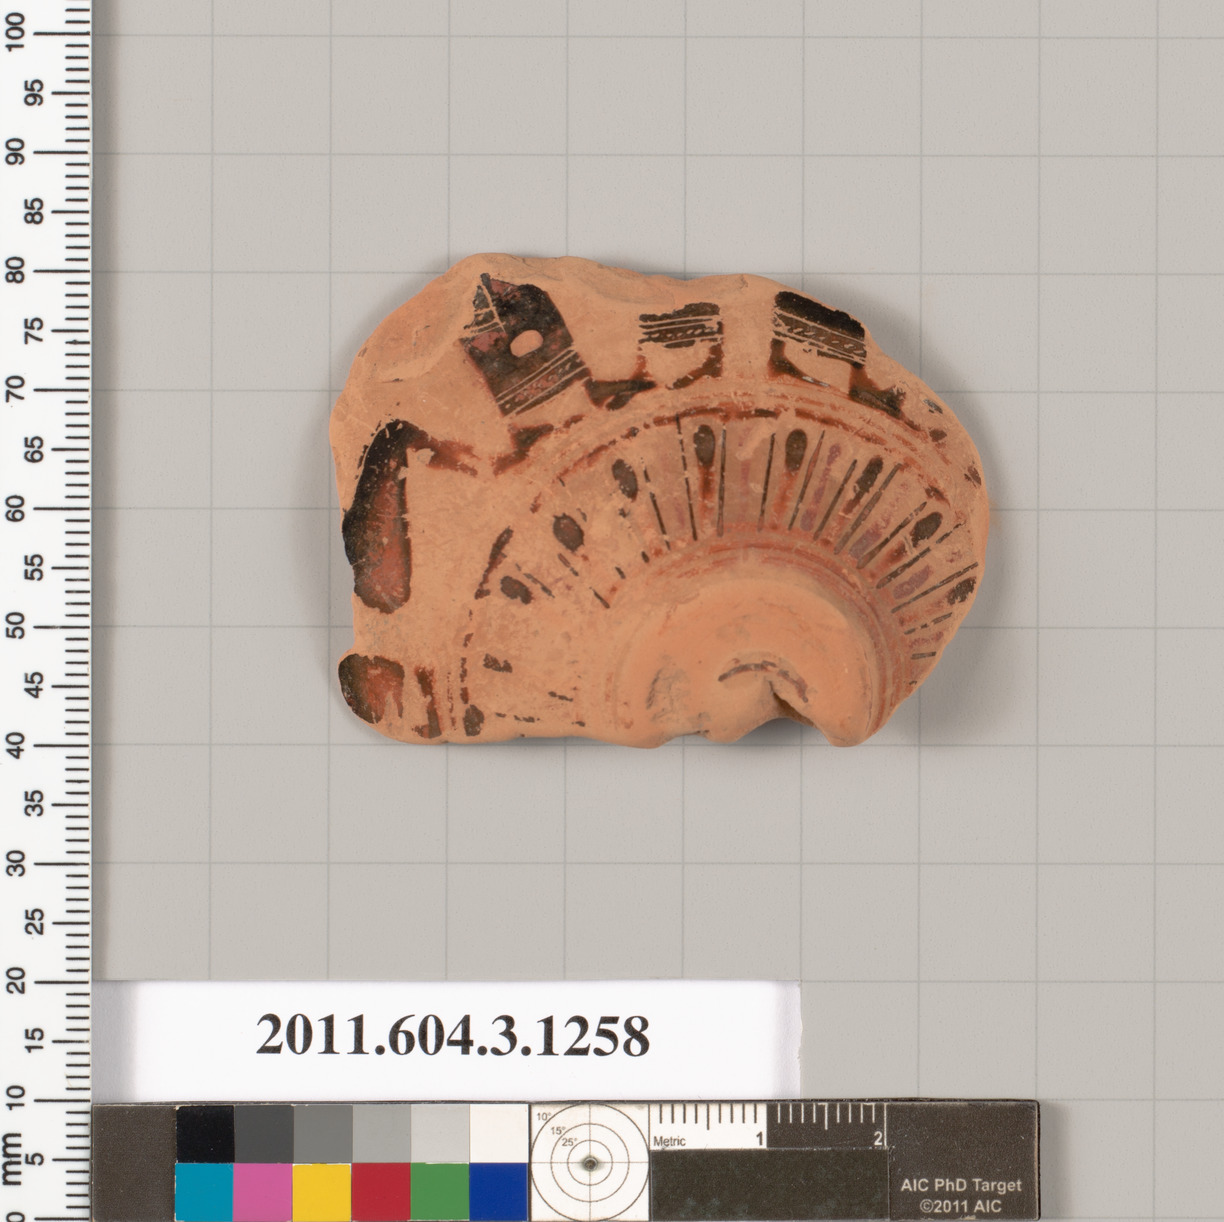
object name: skyphos fragment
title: Terracotta fragment of a skyphos (deep drinking cup)?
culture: greek, attic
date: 600-501 BCE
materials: terracotta